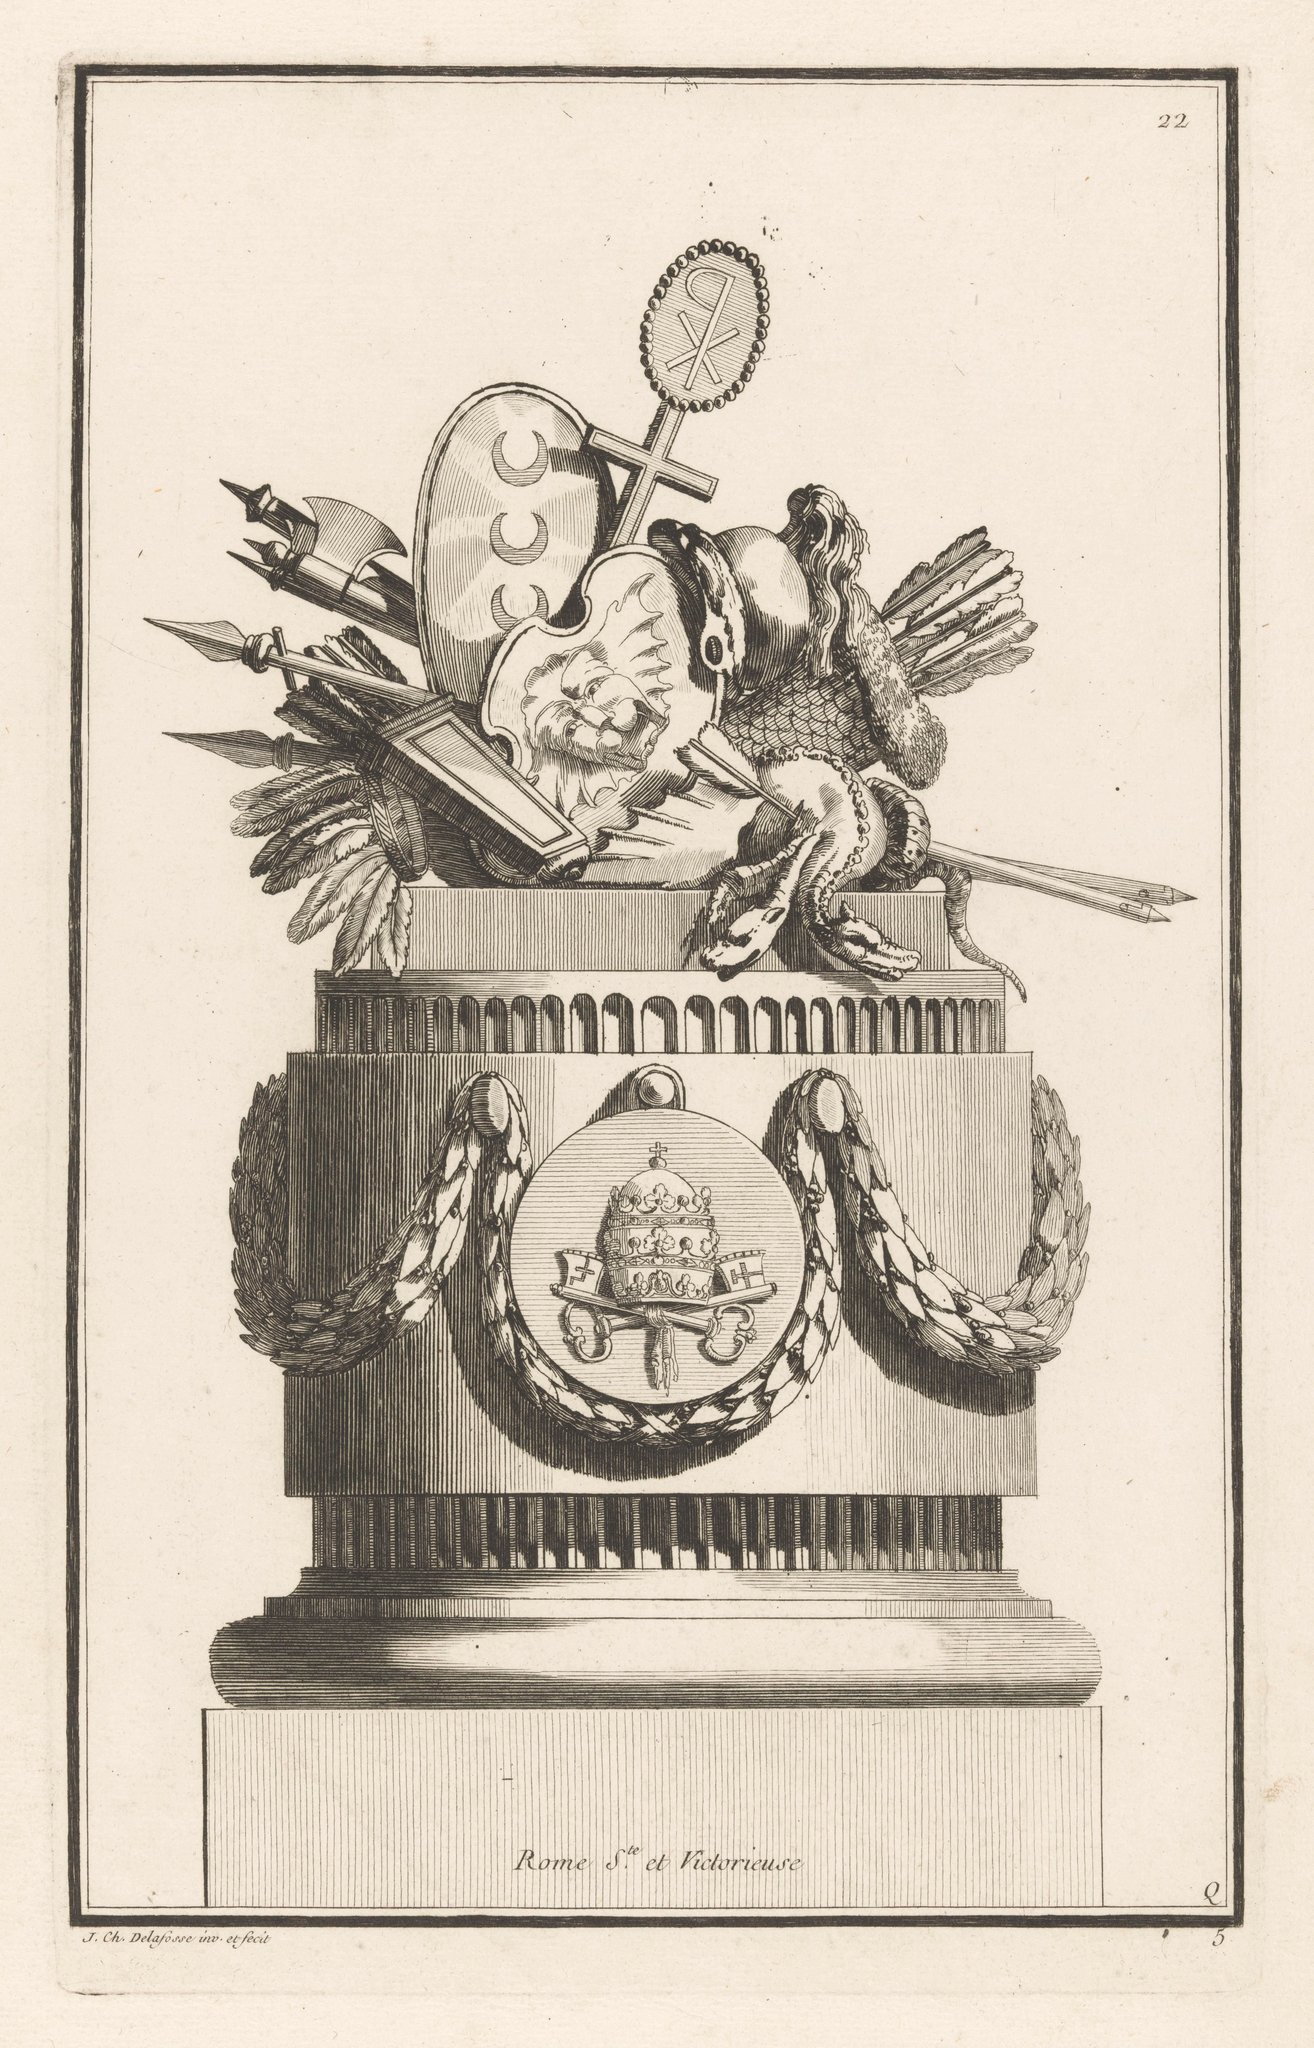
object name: print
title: Nouvelle Iconologie Historique Ou Attributs Hierogliphyques (...)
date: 1768-1771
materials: paper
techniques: engraving, etching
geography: paris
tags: symbols of particular nations, states, districts, etc. (+ city; municipal), pedestal of a piece of sculpture (perhaps in the form of a herm), rome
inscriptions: collector's mark: Lugt 2760, collector's mark: Lugt 2228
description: Een voetstuk met guirlandes en een medaillon met de pauselijke tiara en sleutels. Op het voetstuk liggen wapens, een helm, een tweekoppige draak, een schild met een gevleugelde kop en een schild met drie manen. Prentnummer 22.